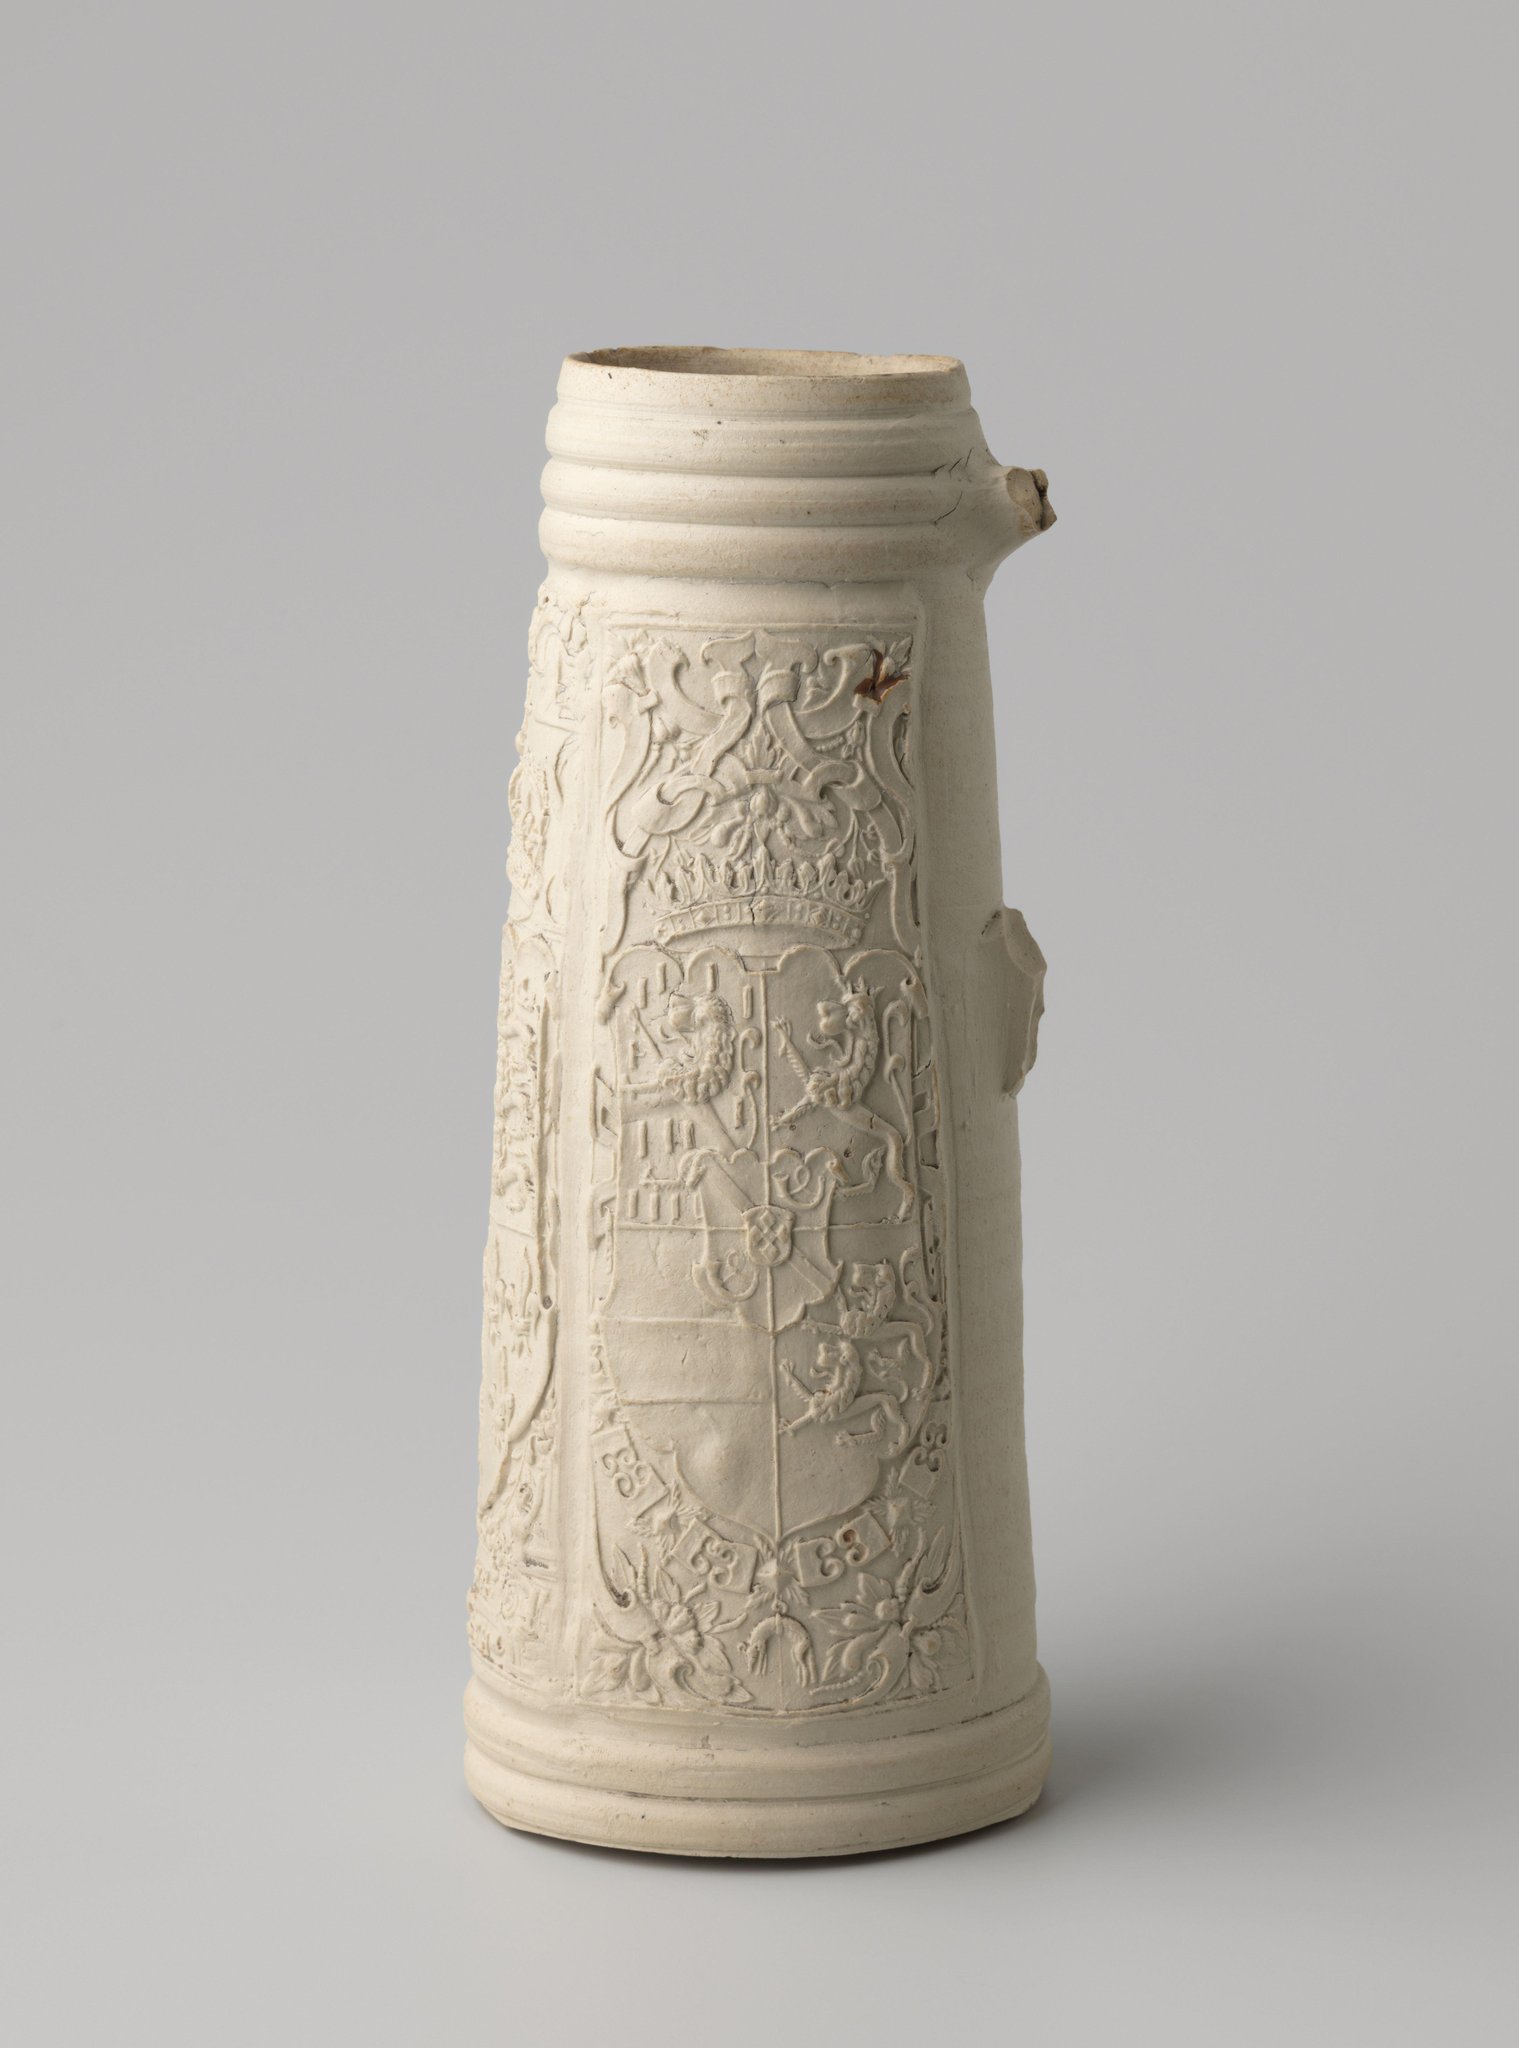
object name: jug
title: Tankard (schnelle) with the coat of arms of Spain, England and the House of Orange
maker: Anonymous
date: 1574-1600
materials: glaze, stoneware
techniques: firing, forming, relief, turning, vitrification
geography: siegburg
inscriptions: date: ‘1574’, signature: ‘H.H.’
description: Kruik (schnelle) van steengoed met cilindervormig, taps toelopend lichaam. Het oor en de bodem ontbreken. Profielen onder de rand en boven de voet. Op het lichaam in reliëf driemaal een gedrukt en opgelegd, langwerpig vak met daarin het gekroonde wapen van Engeland, Spanje of Oranje Nassau. Onder het middelste wapen de datering '1574' en het signatuur 'H.H.'. Bovenin de vakken rolwerk, engelen of bladranken. Siegburg.